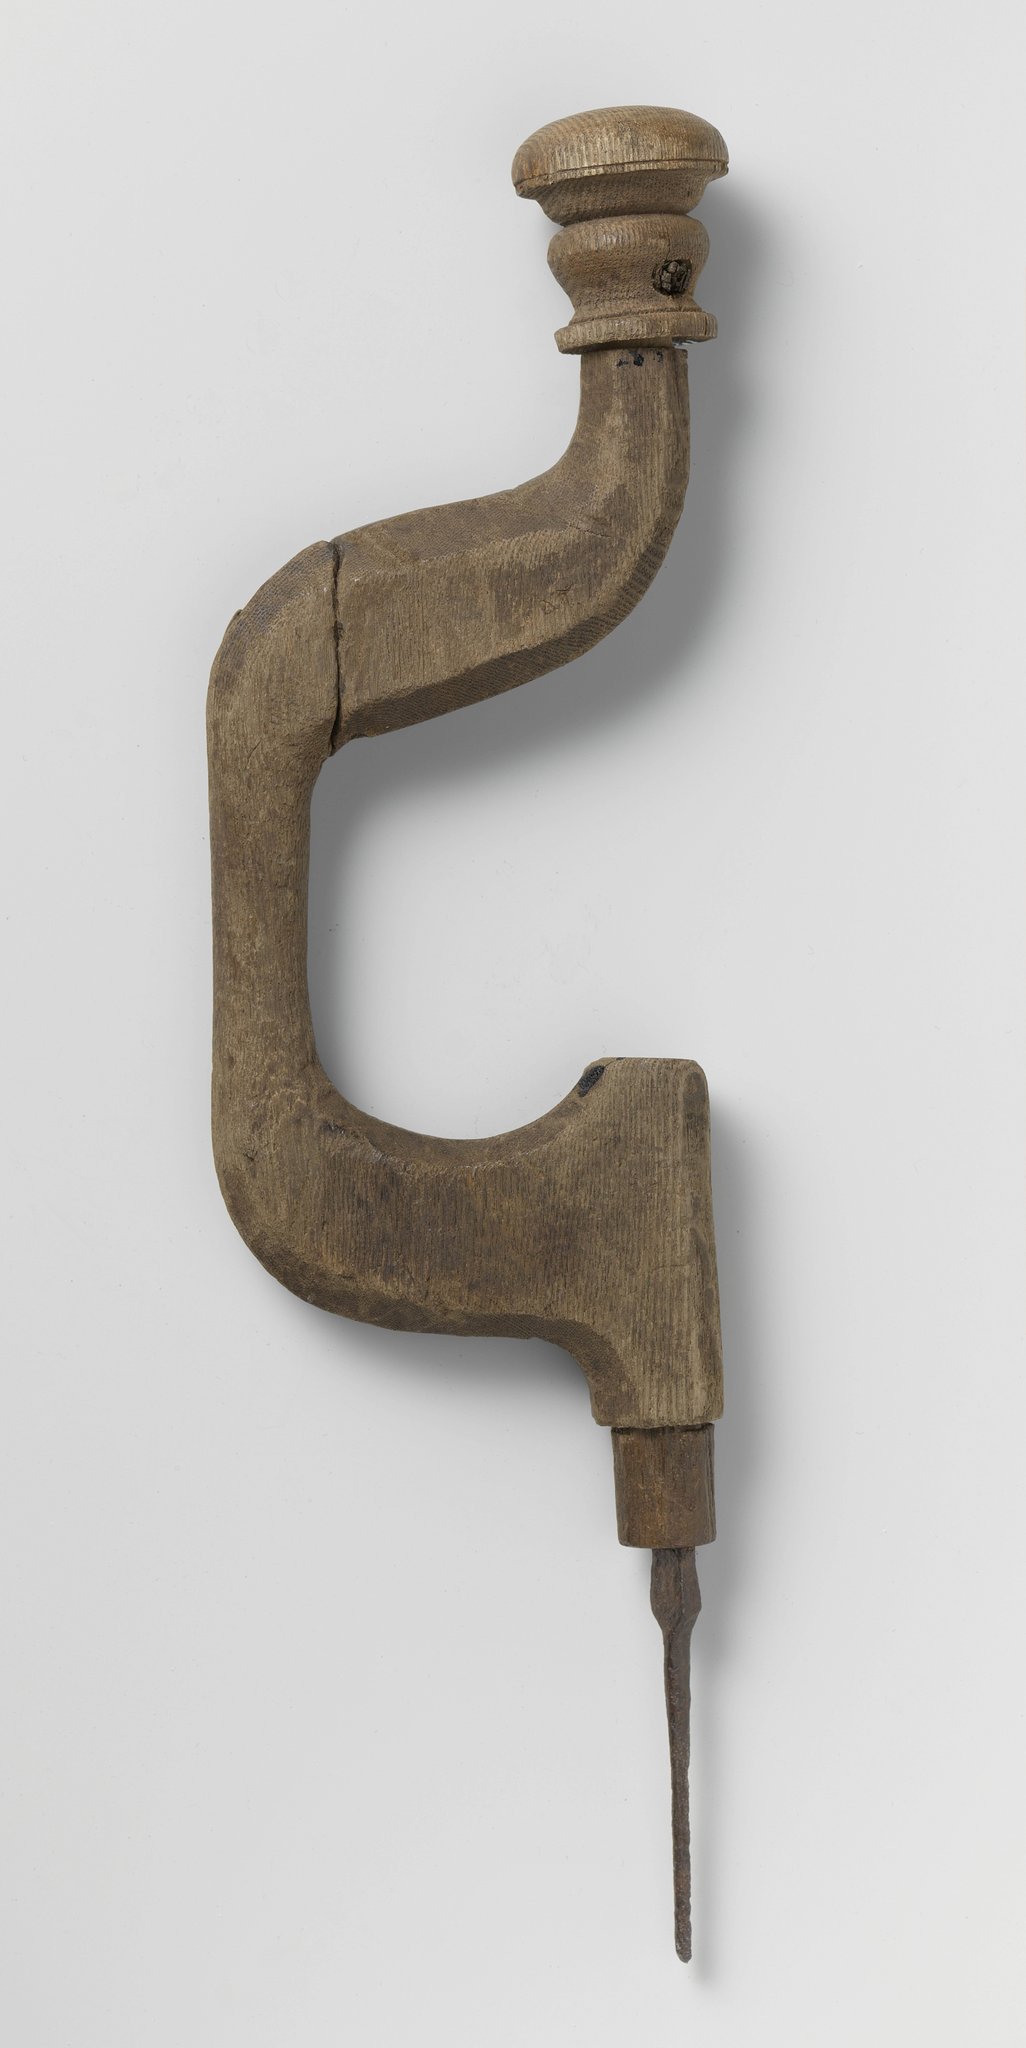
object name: drill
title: Tools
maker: Anonymous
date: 1590-1596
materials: iron, wood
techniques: cutting, forging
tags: willem barendsz., amsterdam, jacob van heemskerck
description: Most of the implements found on Nova Zembla are carpentry and shipbuilding tools. The (surgeon’s) saw is the exception and was probably used to perform amputations.